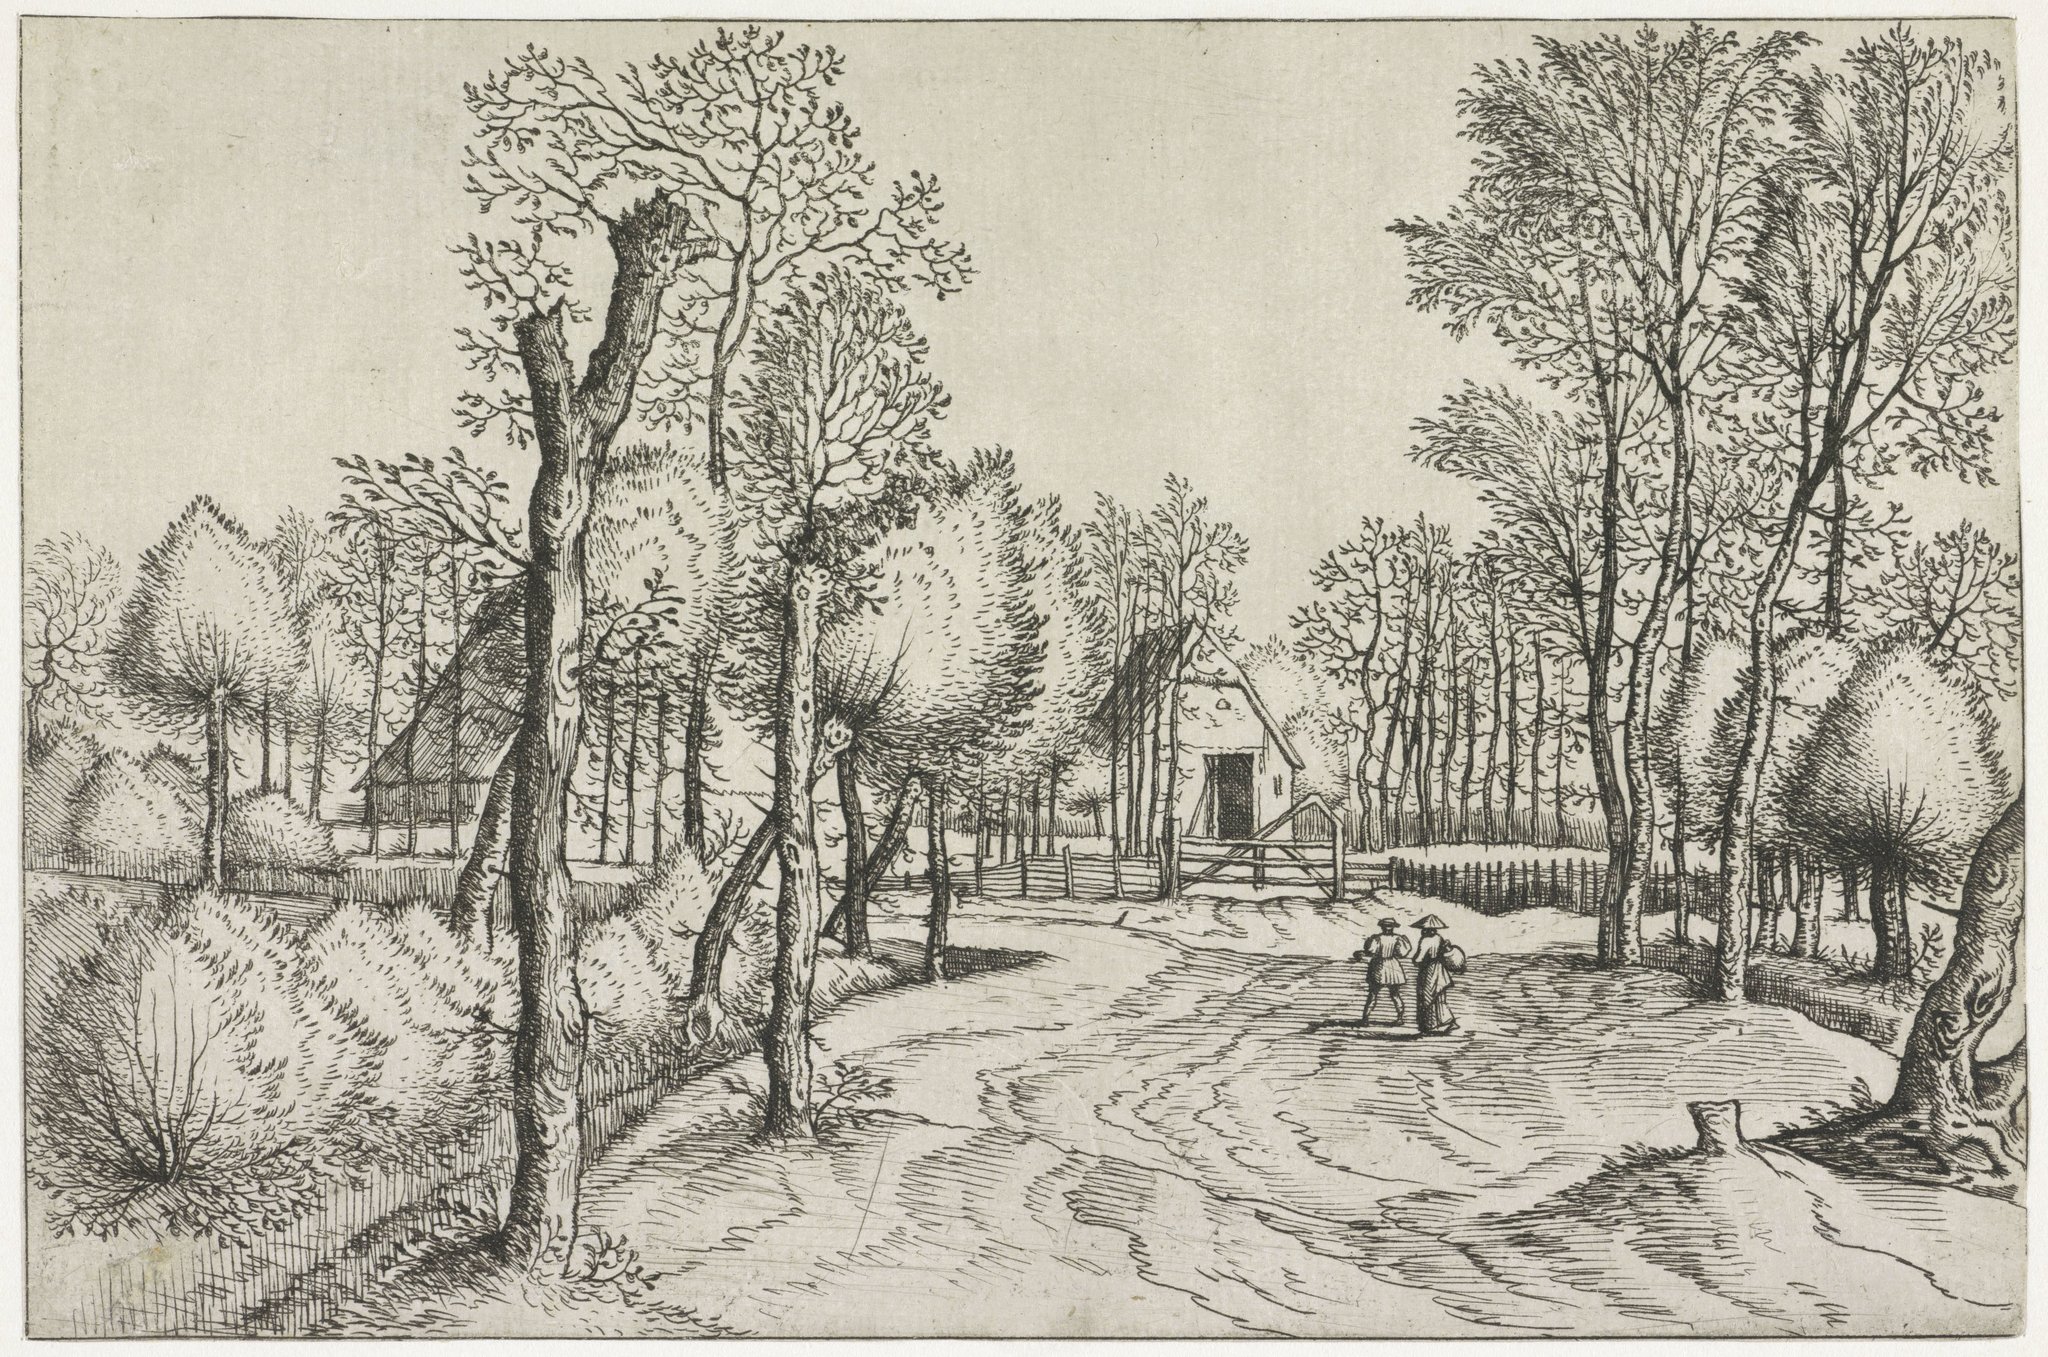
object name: print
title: Gezicht op een landweg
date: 1559-1561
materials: paper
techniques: etching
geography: antwerp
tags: road, path, farm or solitary house in landscape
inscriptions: collector's mark: Lugt 2228, collector's mark: Lugt 2760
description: Gezicht op een weg waarop een man en een vrouw lopen. Aan weerszijden bomen. Op de achtergrond boerderijen.